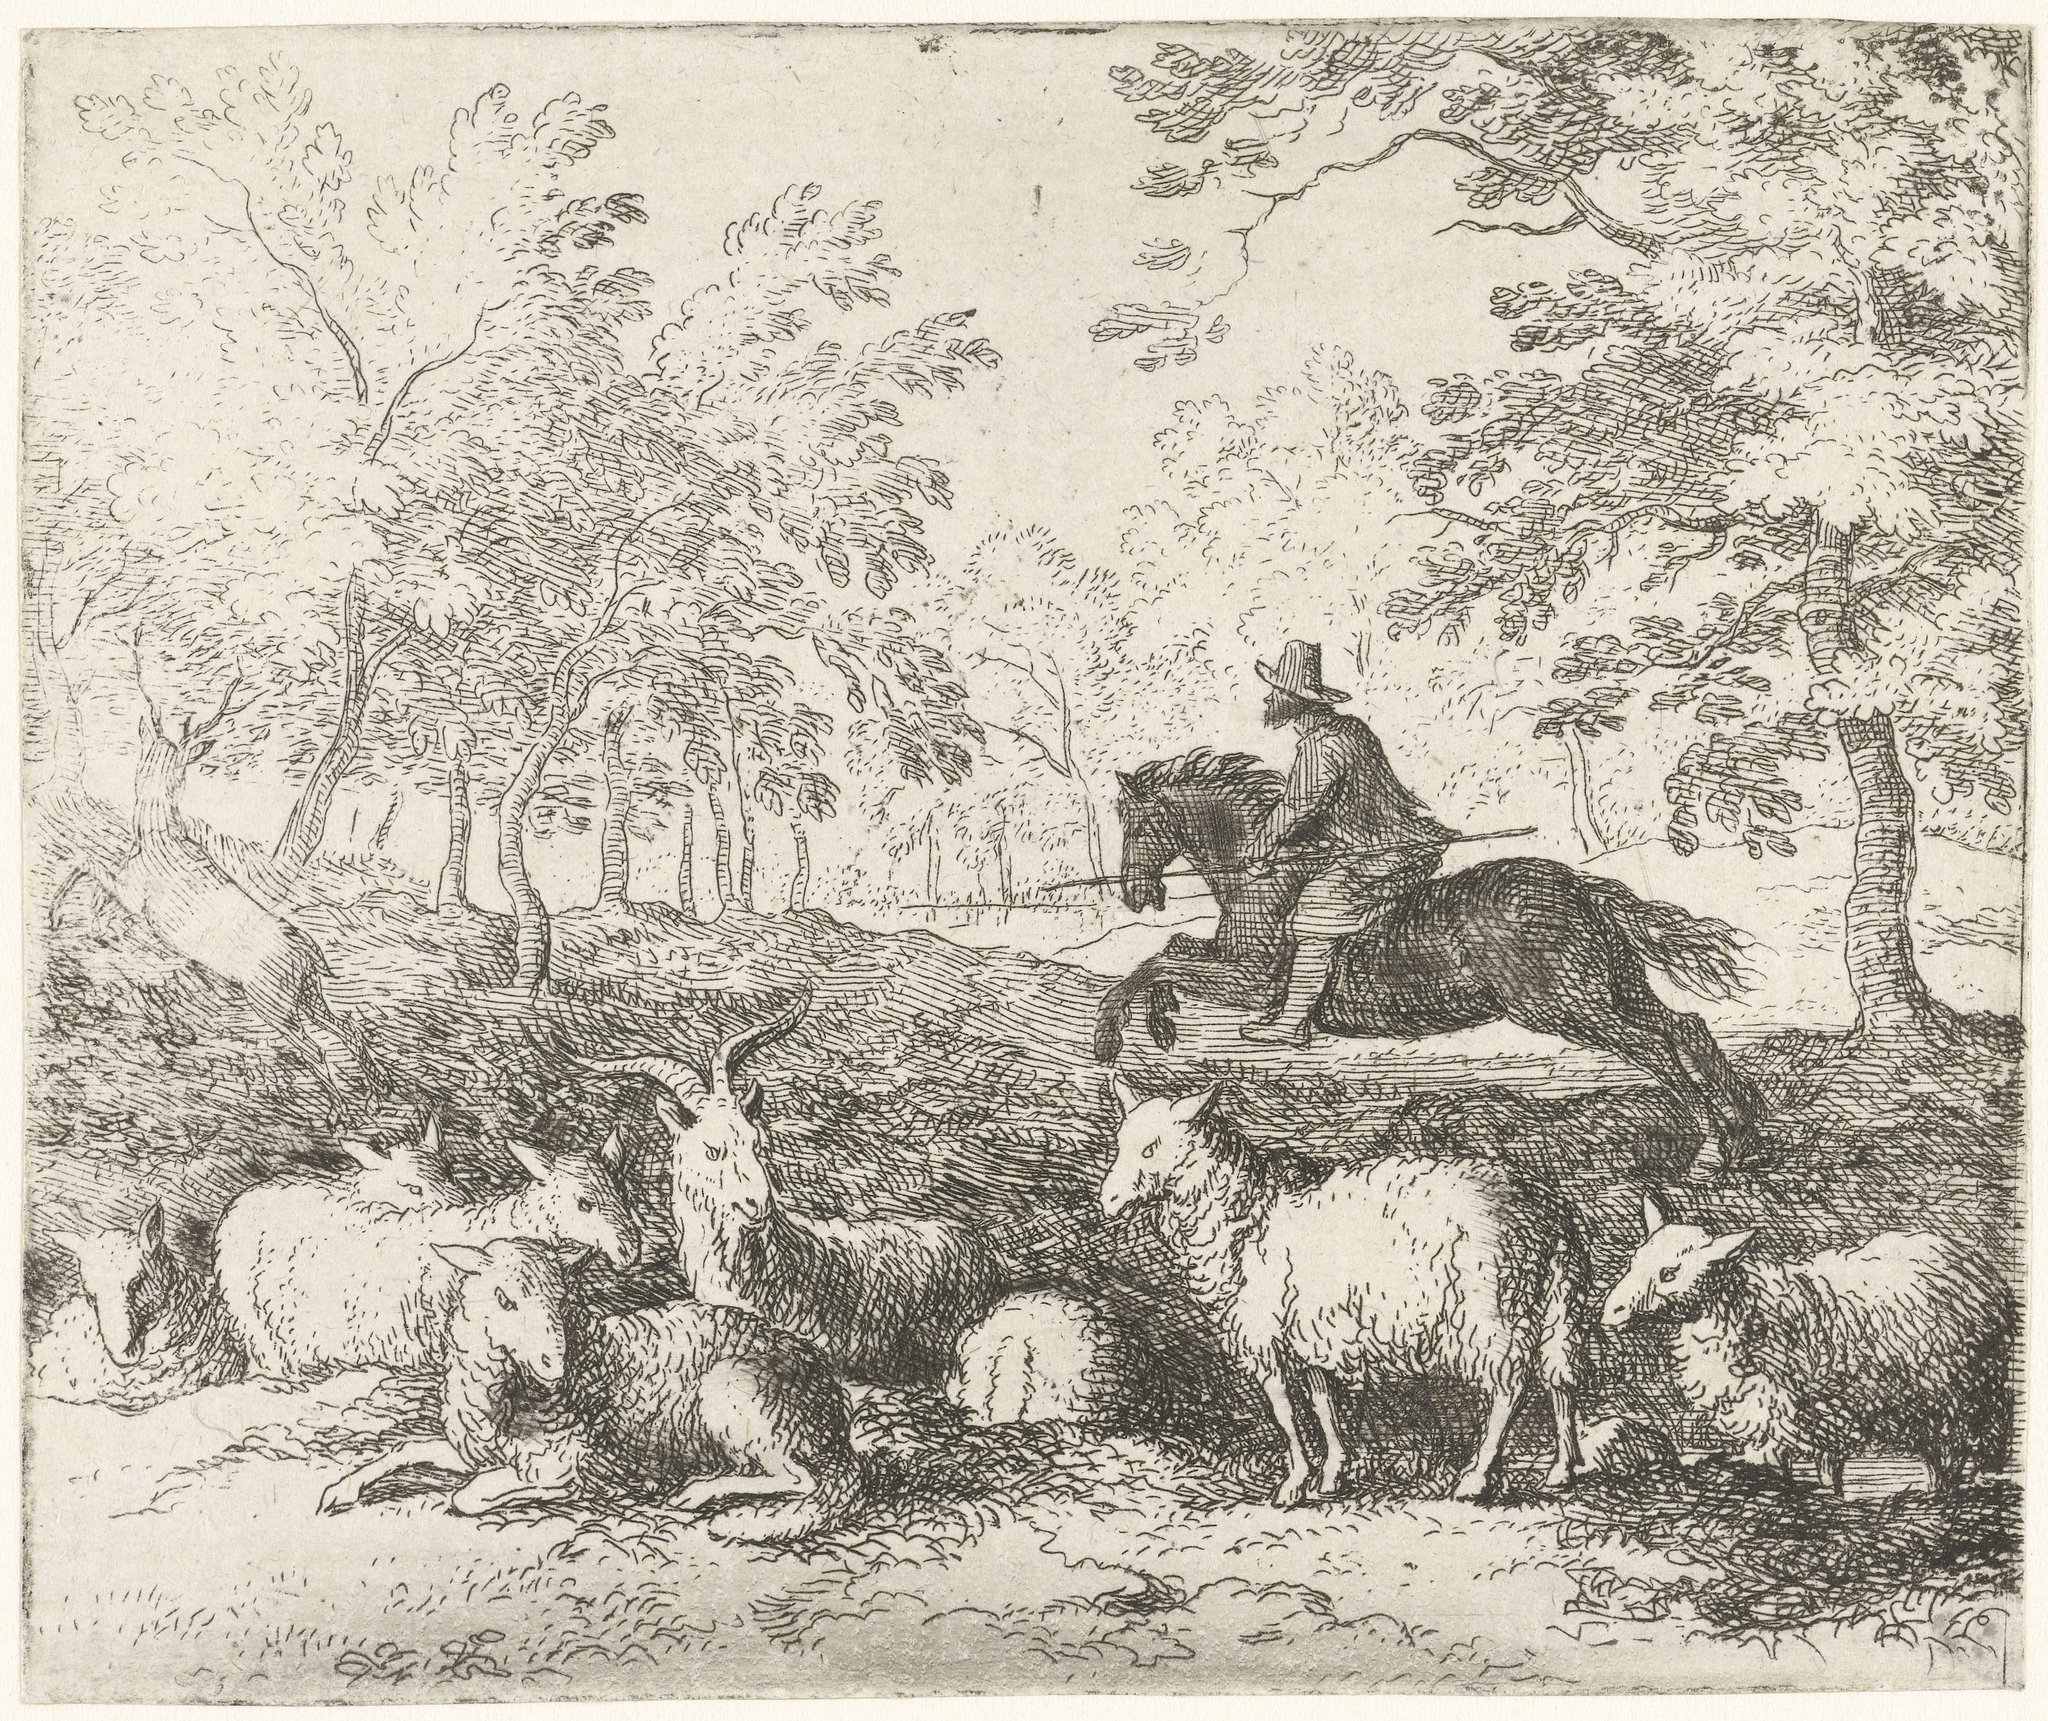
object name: print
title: Reinaert de vos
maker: allaert van everdingen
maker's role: draughtsman, painter, print maker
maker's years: 1621-1675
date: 1665-1675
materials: paper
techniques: etching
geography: netherlands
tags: riding a horse, ass, or mule; rider, horseman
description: Landschap met schapen en op de achtergrond een ruiter te paard.